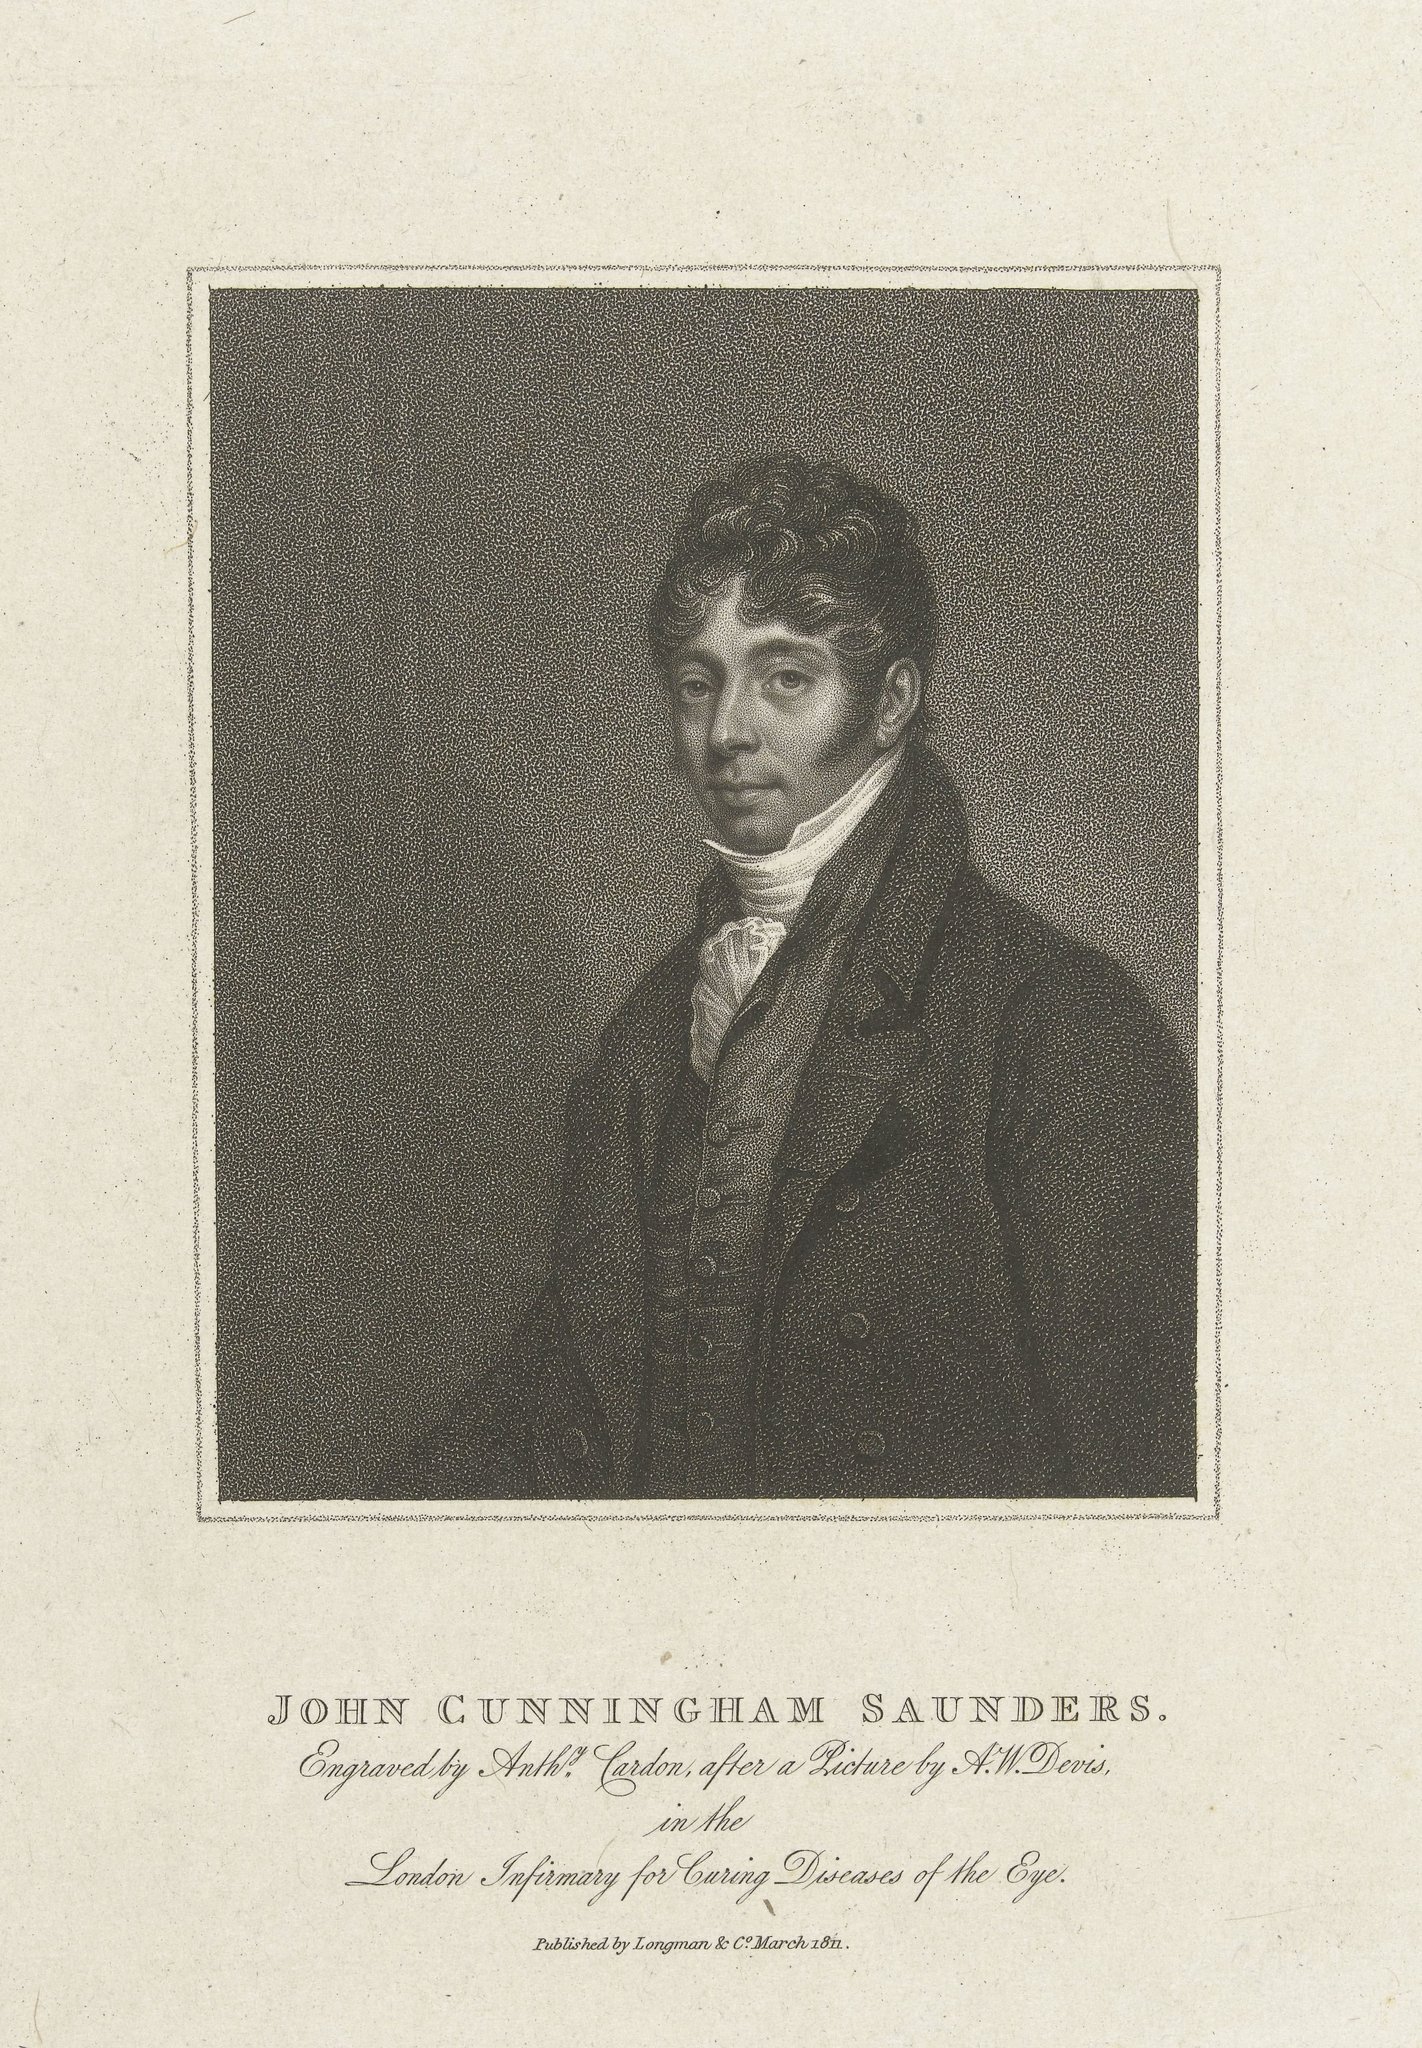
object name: print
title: Portret van John Cunningham Saunders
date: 1811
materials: paper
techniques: etching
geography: london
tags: john cunningham saunders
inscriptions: collector's mark: Lugt 2228